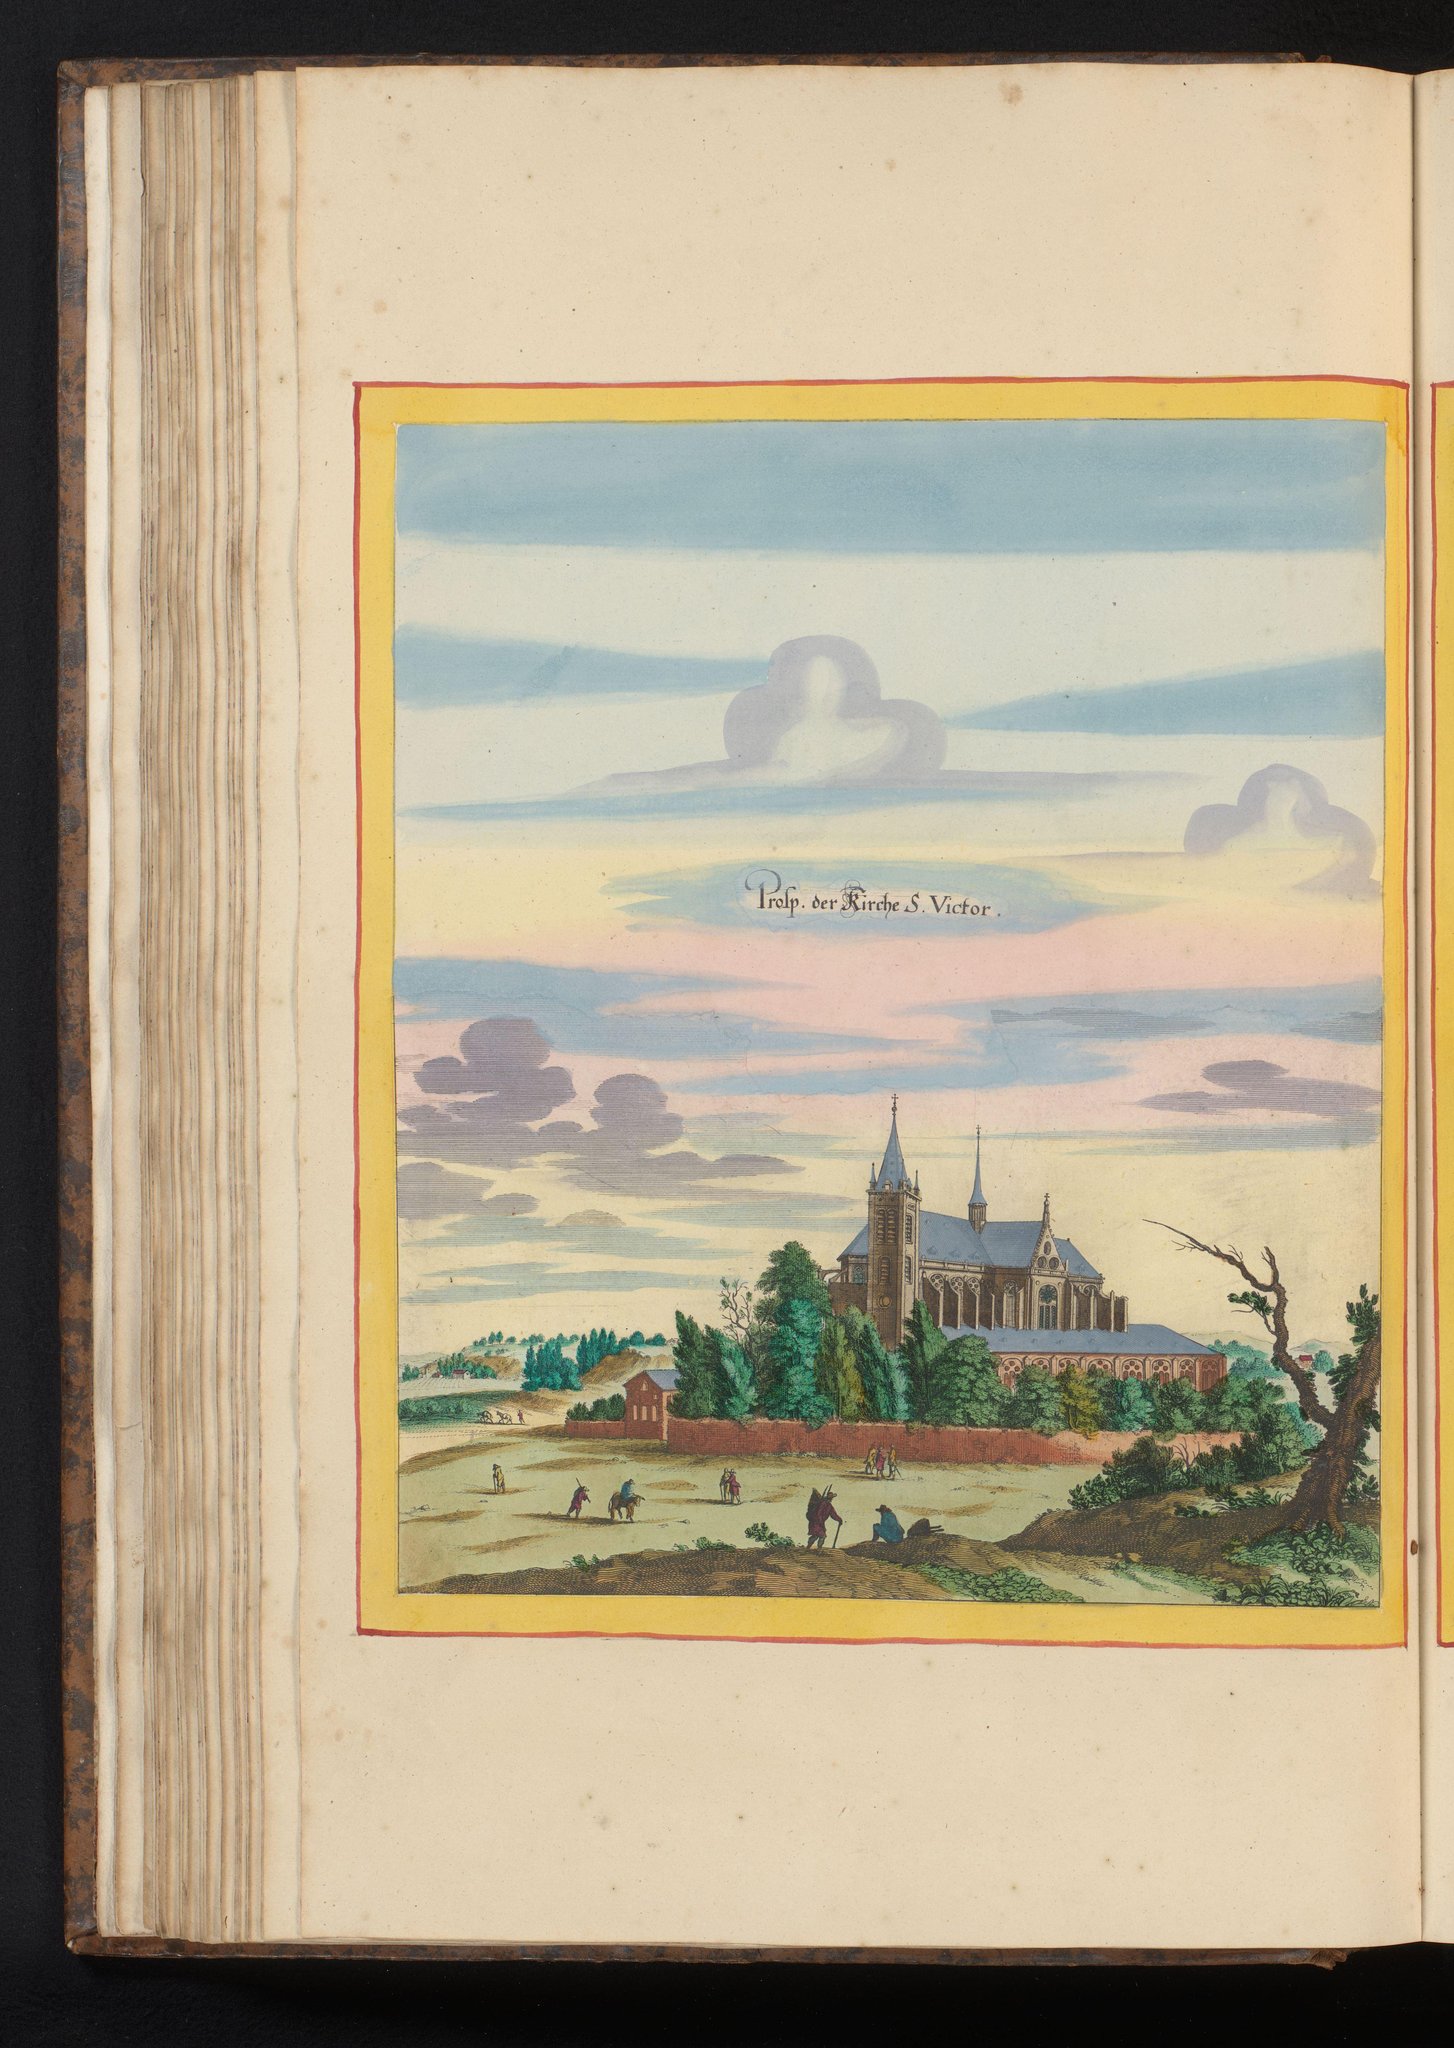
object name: print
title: Gezicht op de kerk en klooster van Saint-Victor te Parijs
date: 1655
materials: paper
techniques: engraving, etching, hand coloring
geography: frankfurt am main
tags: abbey, monastery, convent ~ roman catholic church, church (exterior)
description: Prent origineel vervaardigd als boekillustratie voor: Zeiller, Martin. Topographia Galliae, oder Beschreibung und Contrafaitung der vornehmbsten und bekantisten Oerter in dem mächtigen und grossen Königreich Frankreich, 13 delen. Frankfurt am Main: Caspar Merian, 1655-1661. De prent werd voor het eerst gepubliceerd in deel 1: Topographia Galliae, 1655.